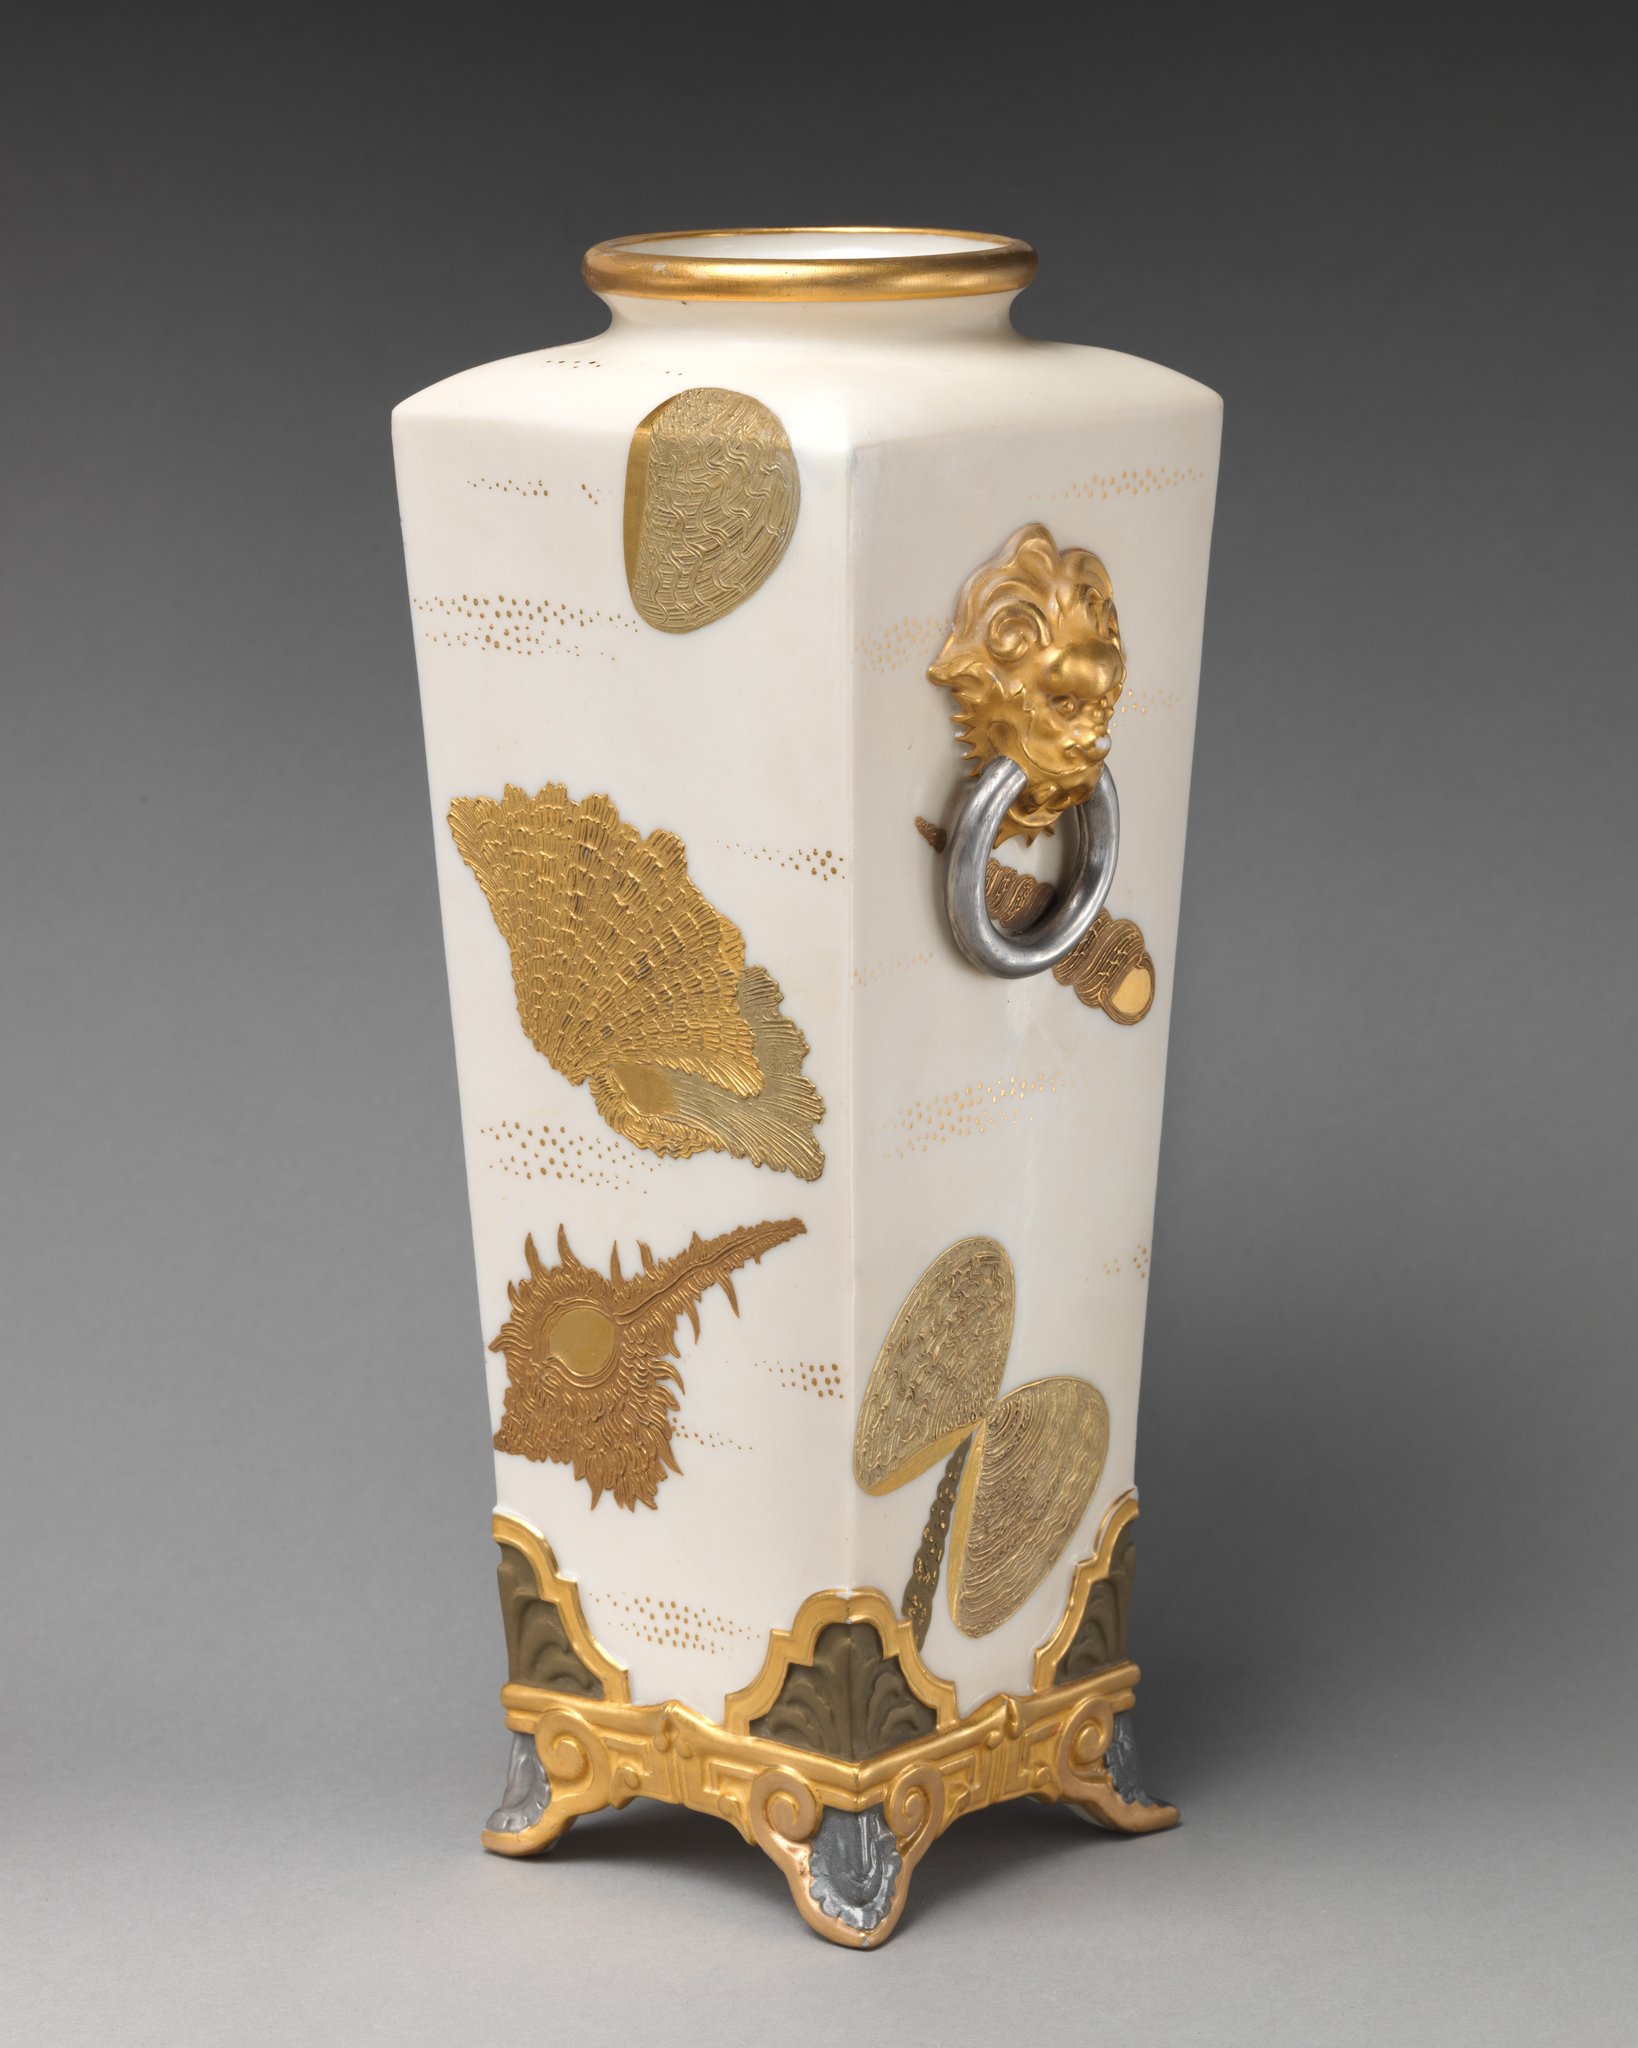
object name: vase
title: Vase with gold sea shell motifs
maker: worcester factory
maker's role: maker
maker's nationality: british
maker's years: 1751-2008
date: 1878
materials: porcelain